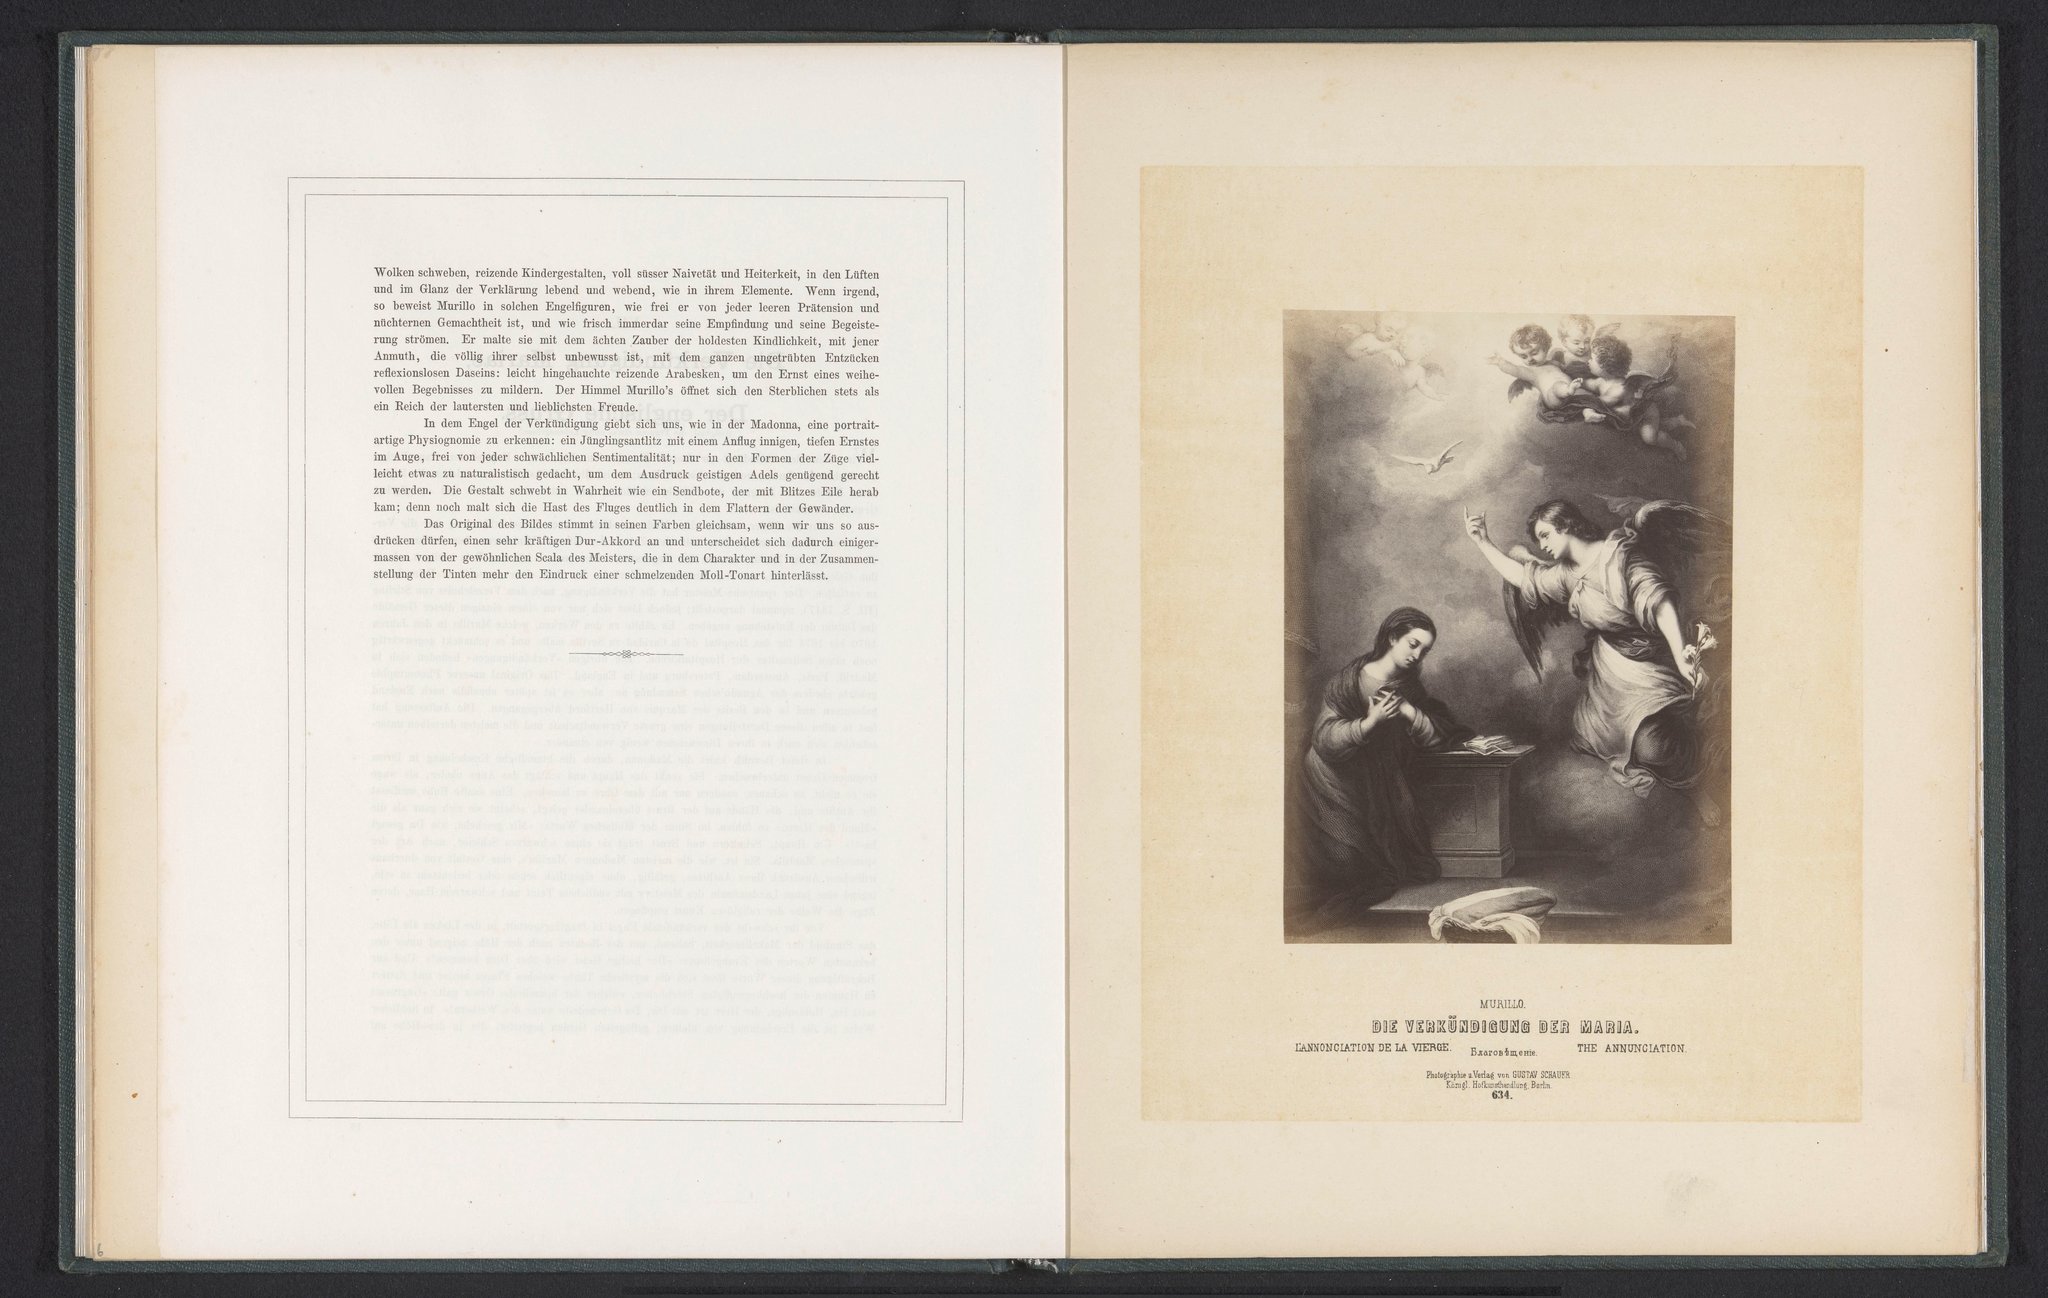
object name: reproduction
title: Fotoreproductie van een prent naar een schilderij van de annunciatie door Bartolomé Esteban Murillo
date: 1850-1860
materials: photographic support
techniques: albumen print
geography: berlin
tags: the annunciation: mary sitting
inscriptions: number: ‘634.’